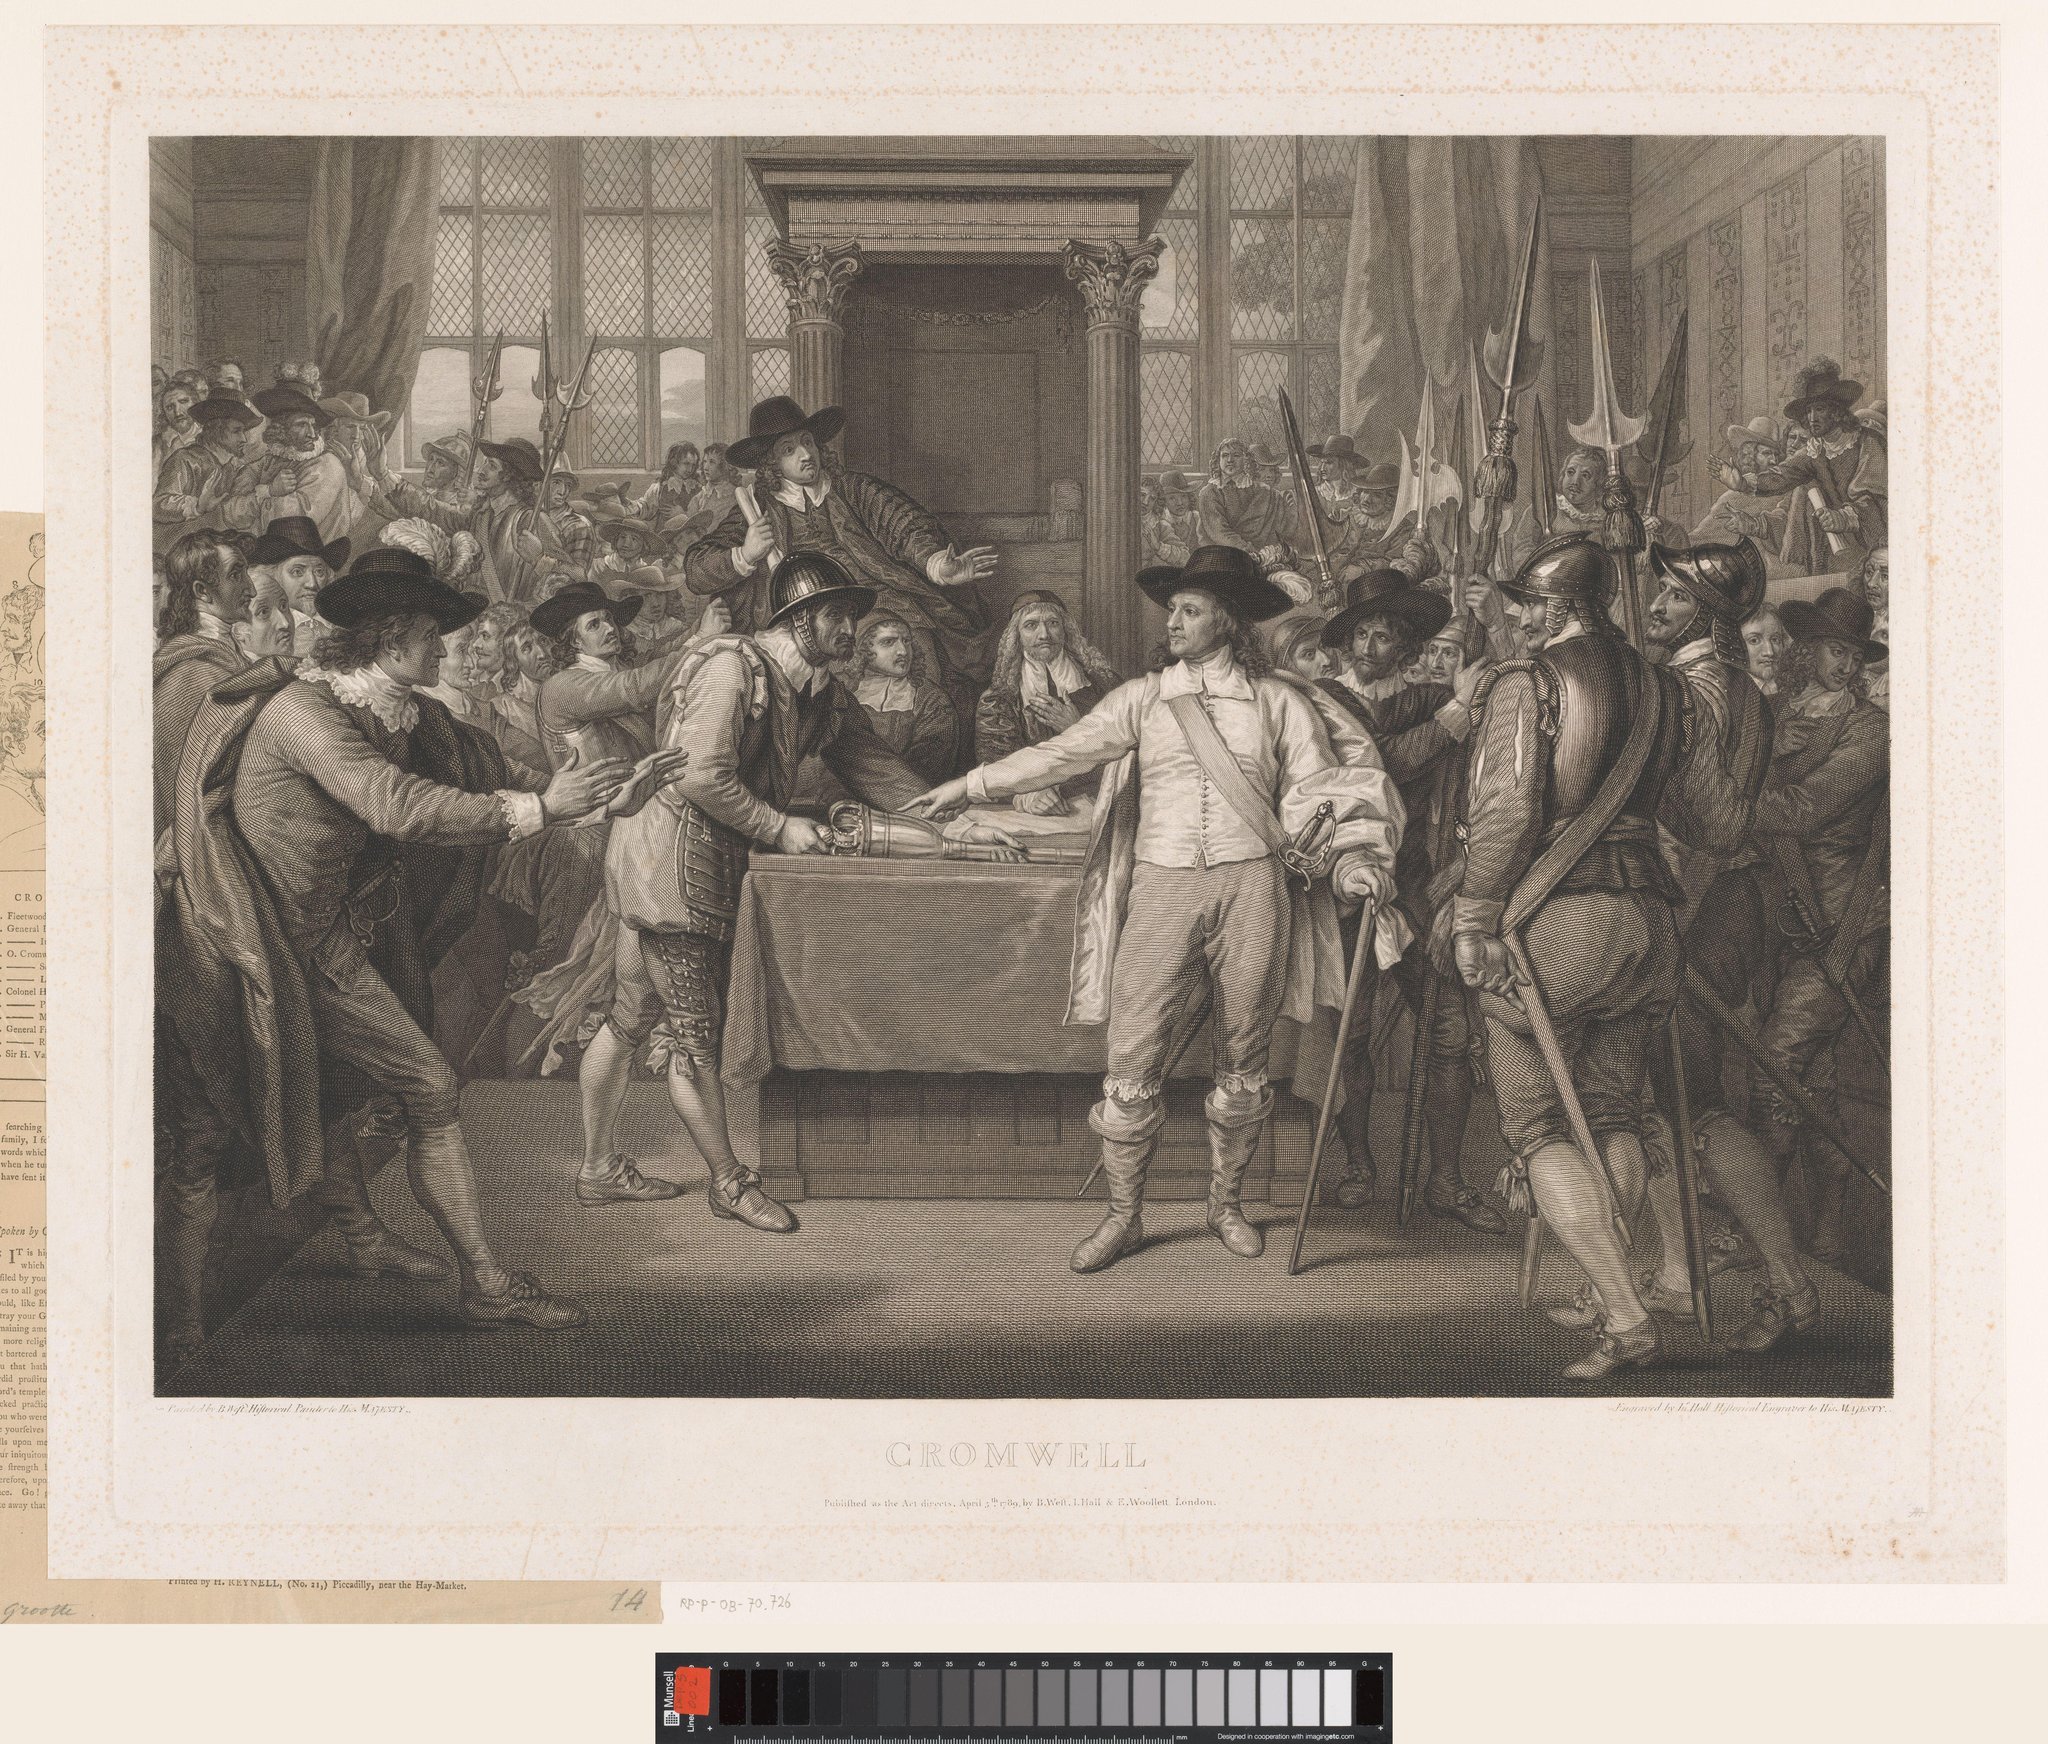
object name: print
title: Oliver Cromwell dissolving the long Parliament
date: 1789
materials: paper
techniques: engraving, etching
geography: london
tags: london, oliver cromwell, presentation of sword ~ installation of a ruler, historical persons, government, the state; 'politica', 'auttorità o potestà' (ripa), revolution, revolt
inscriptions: collector's mark: Lugt 12